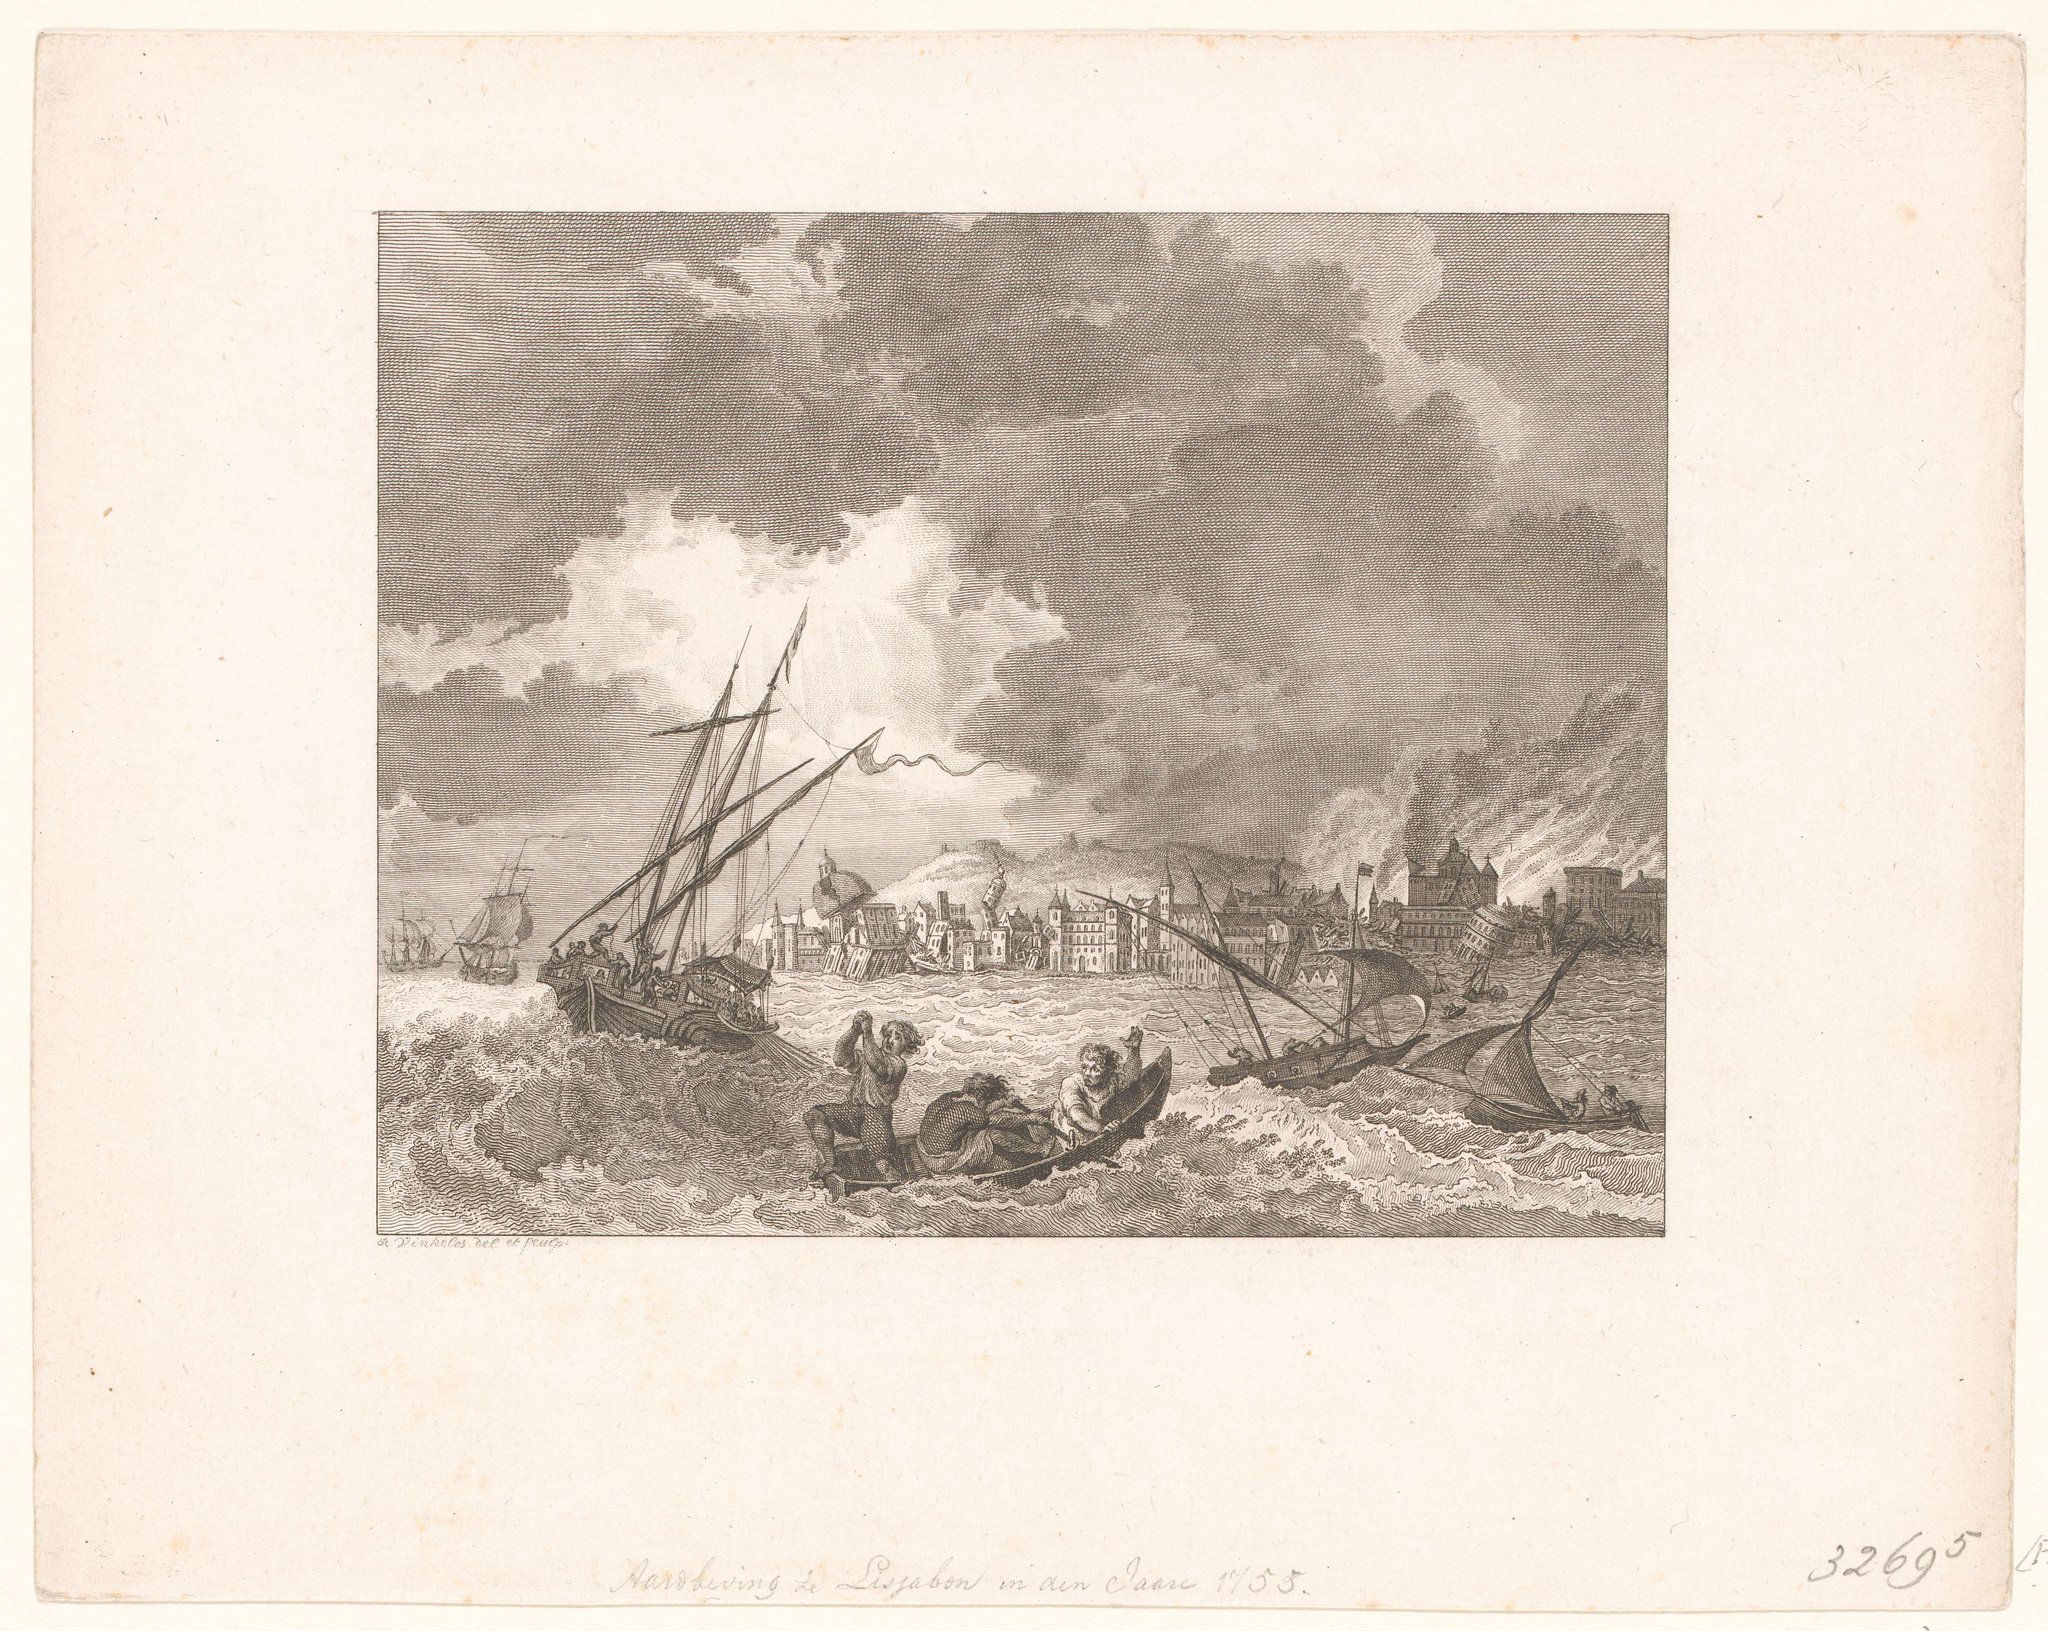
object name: print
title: Aardbeving te Lissabon, 1755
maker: reinier vinkeles (i)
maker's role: draughtsman, print maker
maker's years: 1741-1816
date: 1755-1816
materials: paper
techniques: engraving, etching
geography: amsterdam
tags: on fire, ablaze, rowing-boat, canoe, etc., earthquake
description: Op 1 november 1755 wordt Lissabon getroffen door een zware aardbeving, een brand en een tsunami. Op de voorgrond enkele boten in de problemen. Op de achtergrond Lissabon waar gebrouwen instorten en brand woedt.